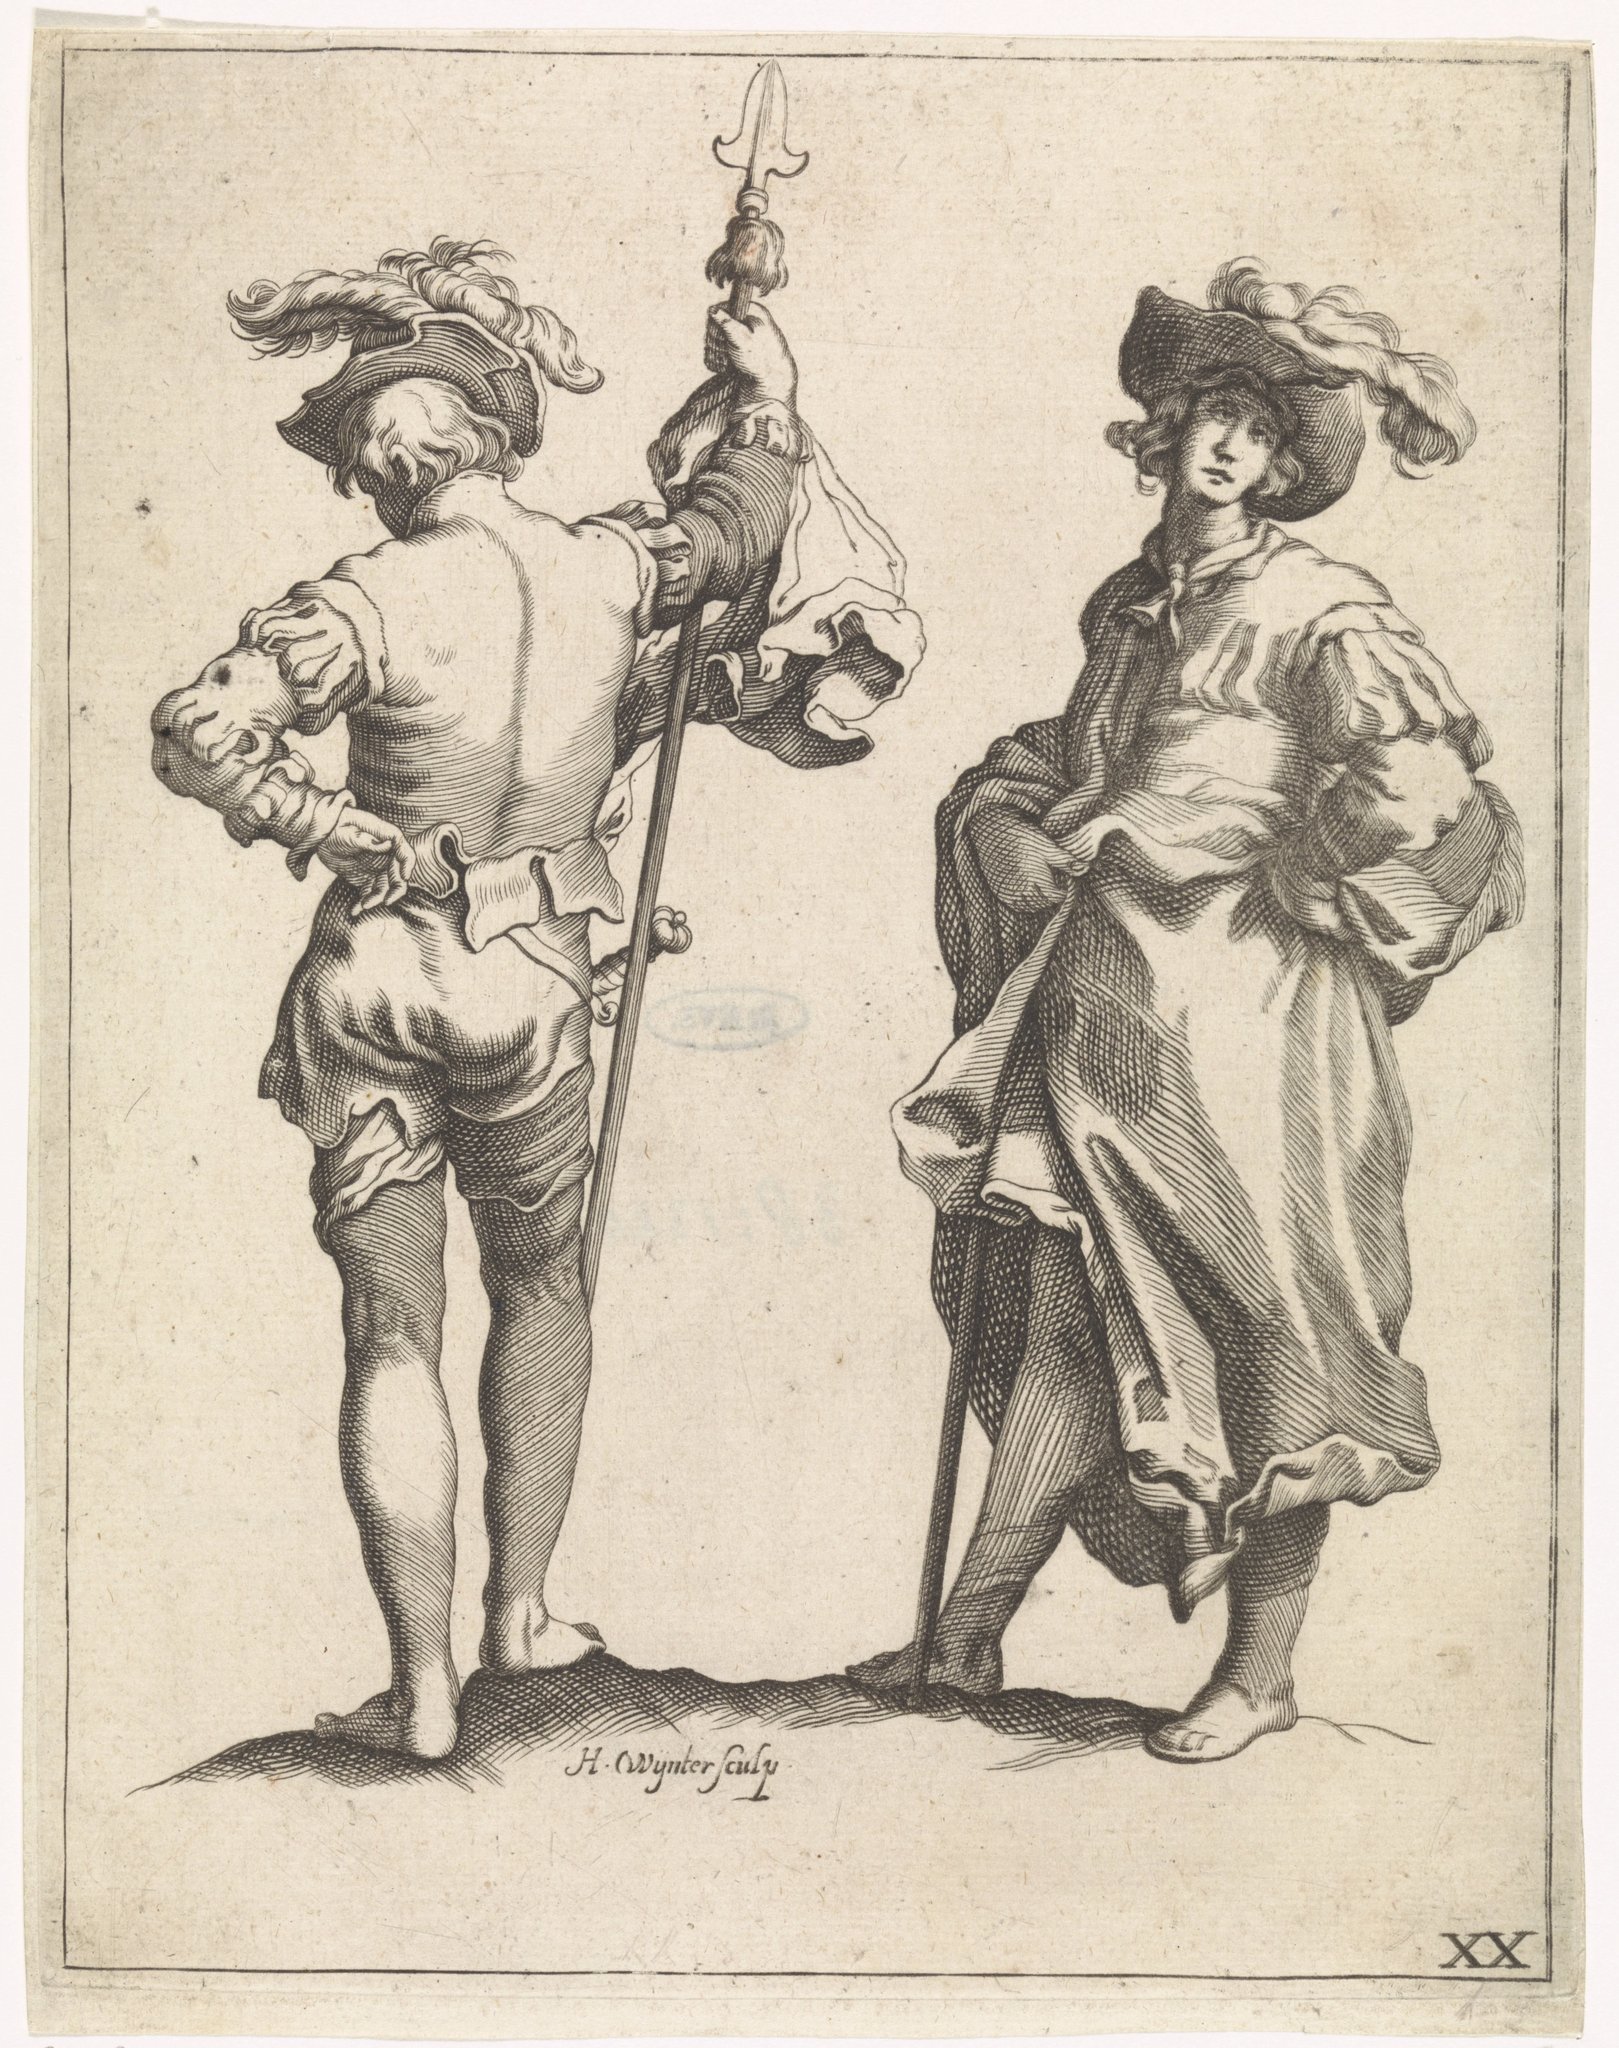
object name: print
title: Twee soldaten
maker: hendrik winter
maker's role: jeweler, print maker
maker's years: 1620-1677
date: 1630-1677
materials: paper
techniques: engraving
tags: the soldier; the soldier's life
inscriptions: collector's mark: Lugt 2760, collector's mark: Lugt 2228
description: Twee soldaten. Links een piekenier op de rug gezien. Rechts een soldaat met een hoed met pluim op het hoofd. Rechtsonder genummerd: XX.